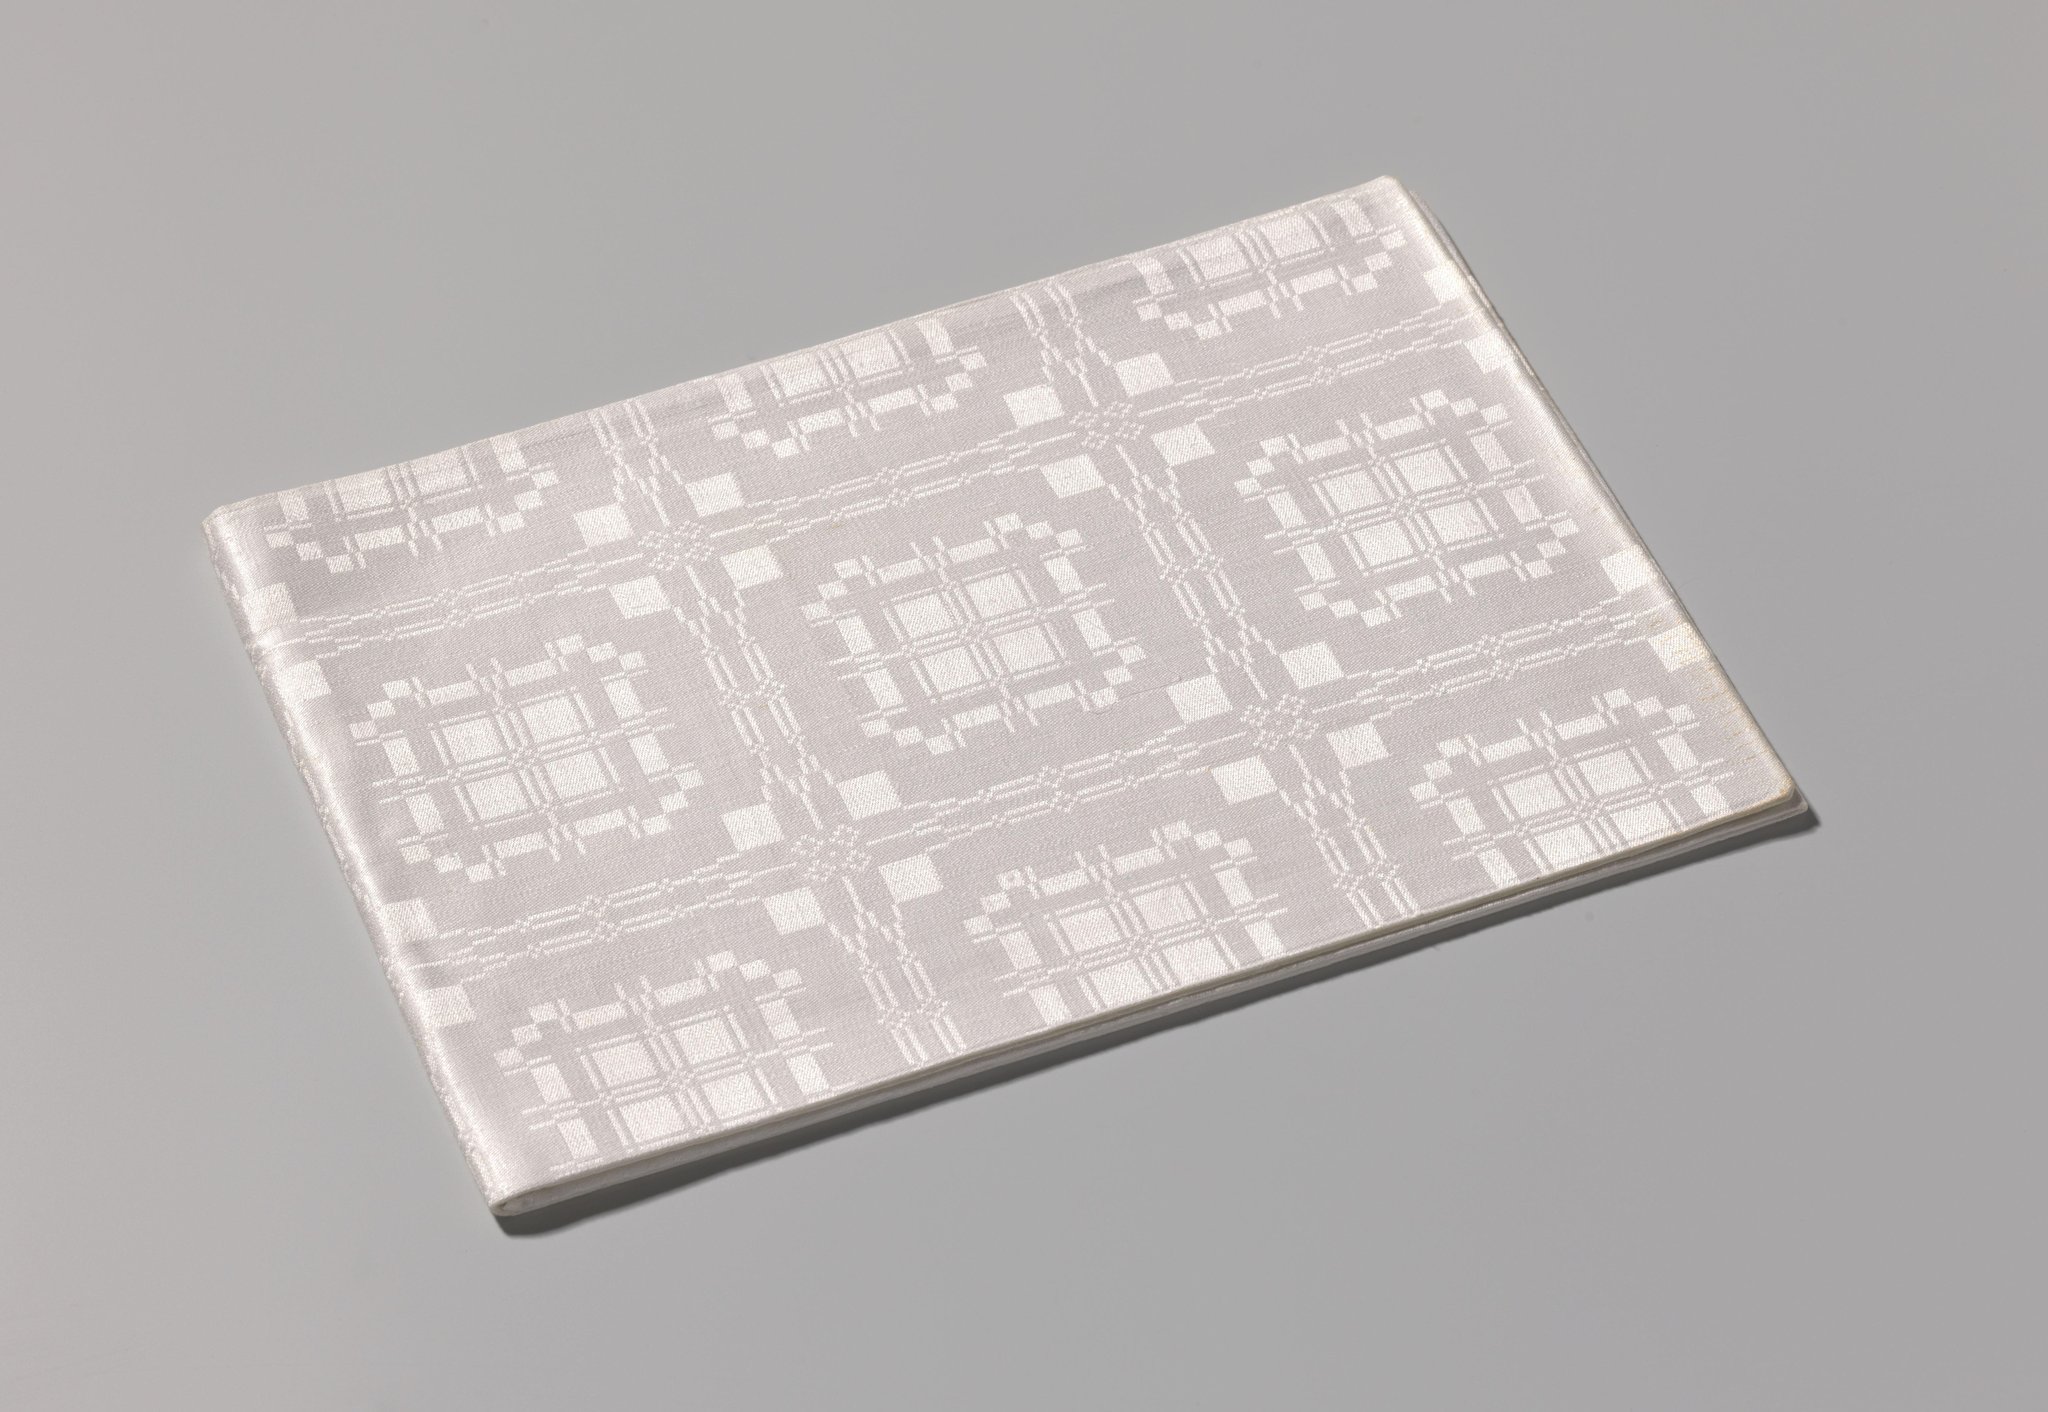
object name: napkin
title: Servet van linnen met pellenpatroon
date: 1400-1950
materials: linen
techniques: peeled fabric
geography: northern netherlands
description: Wit linnendamasten servet met pellenpatroon, merk kroon IS en 36.